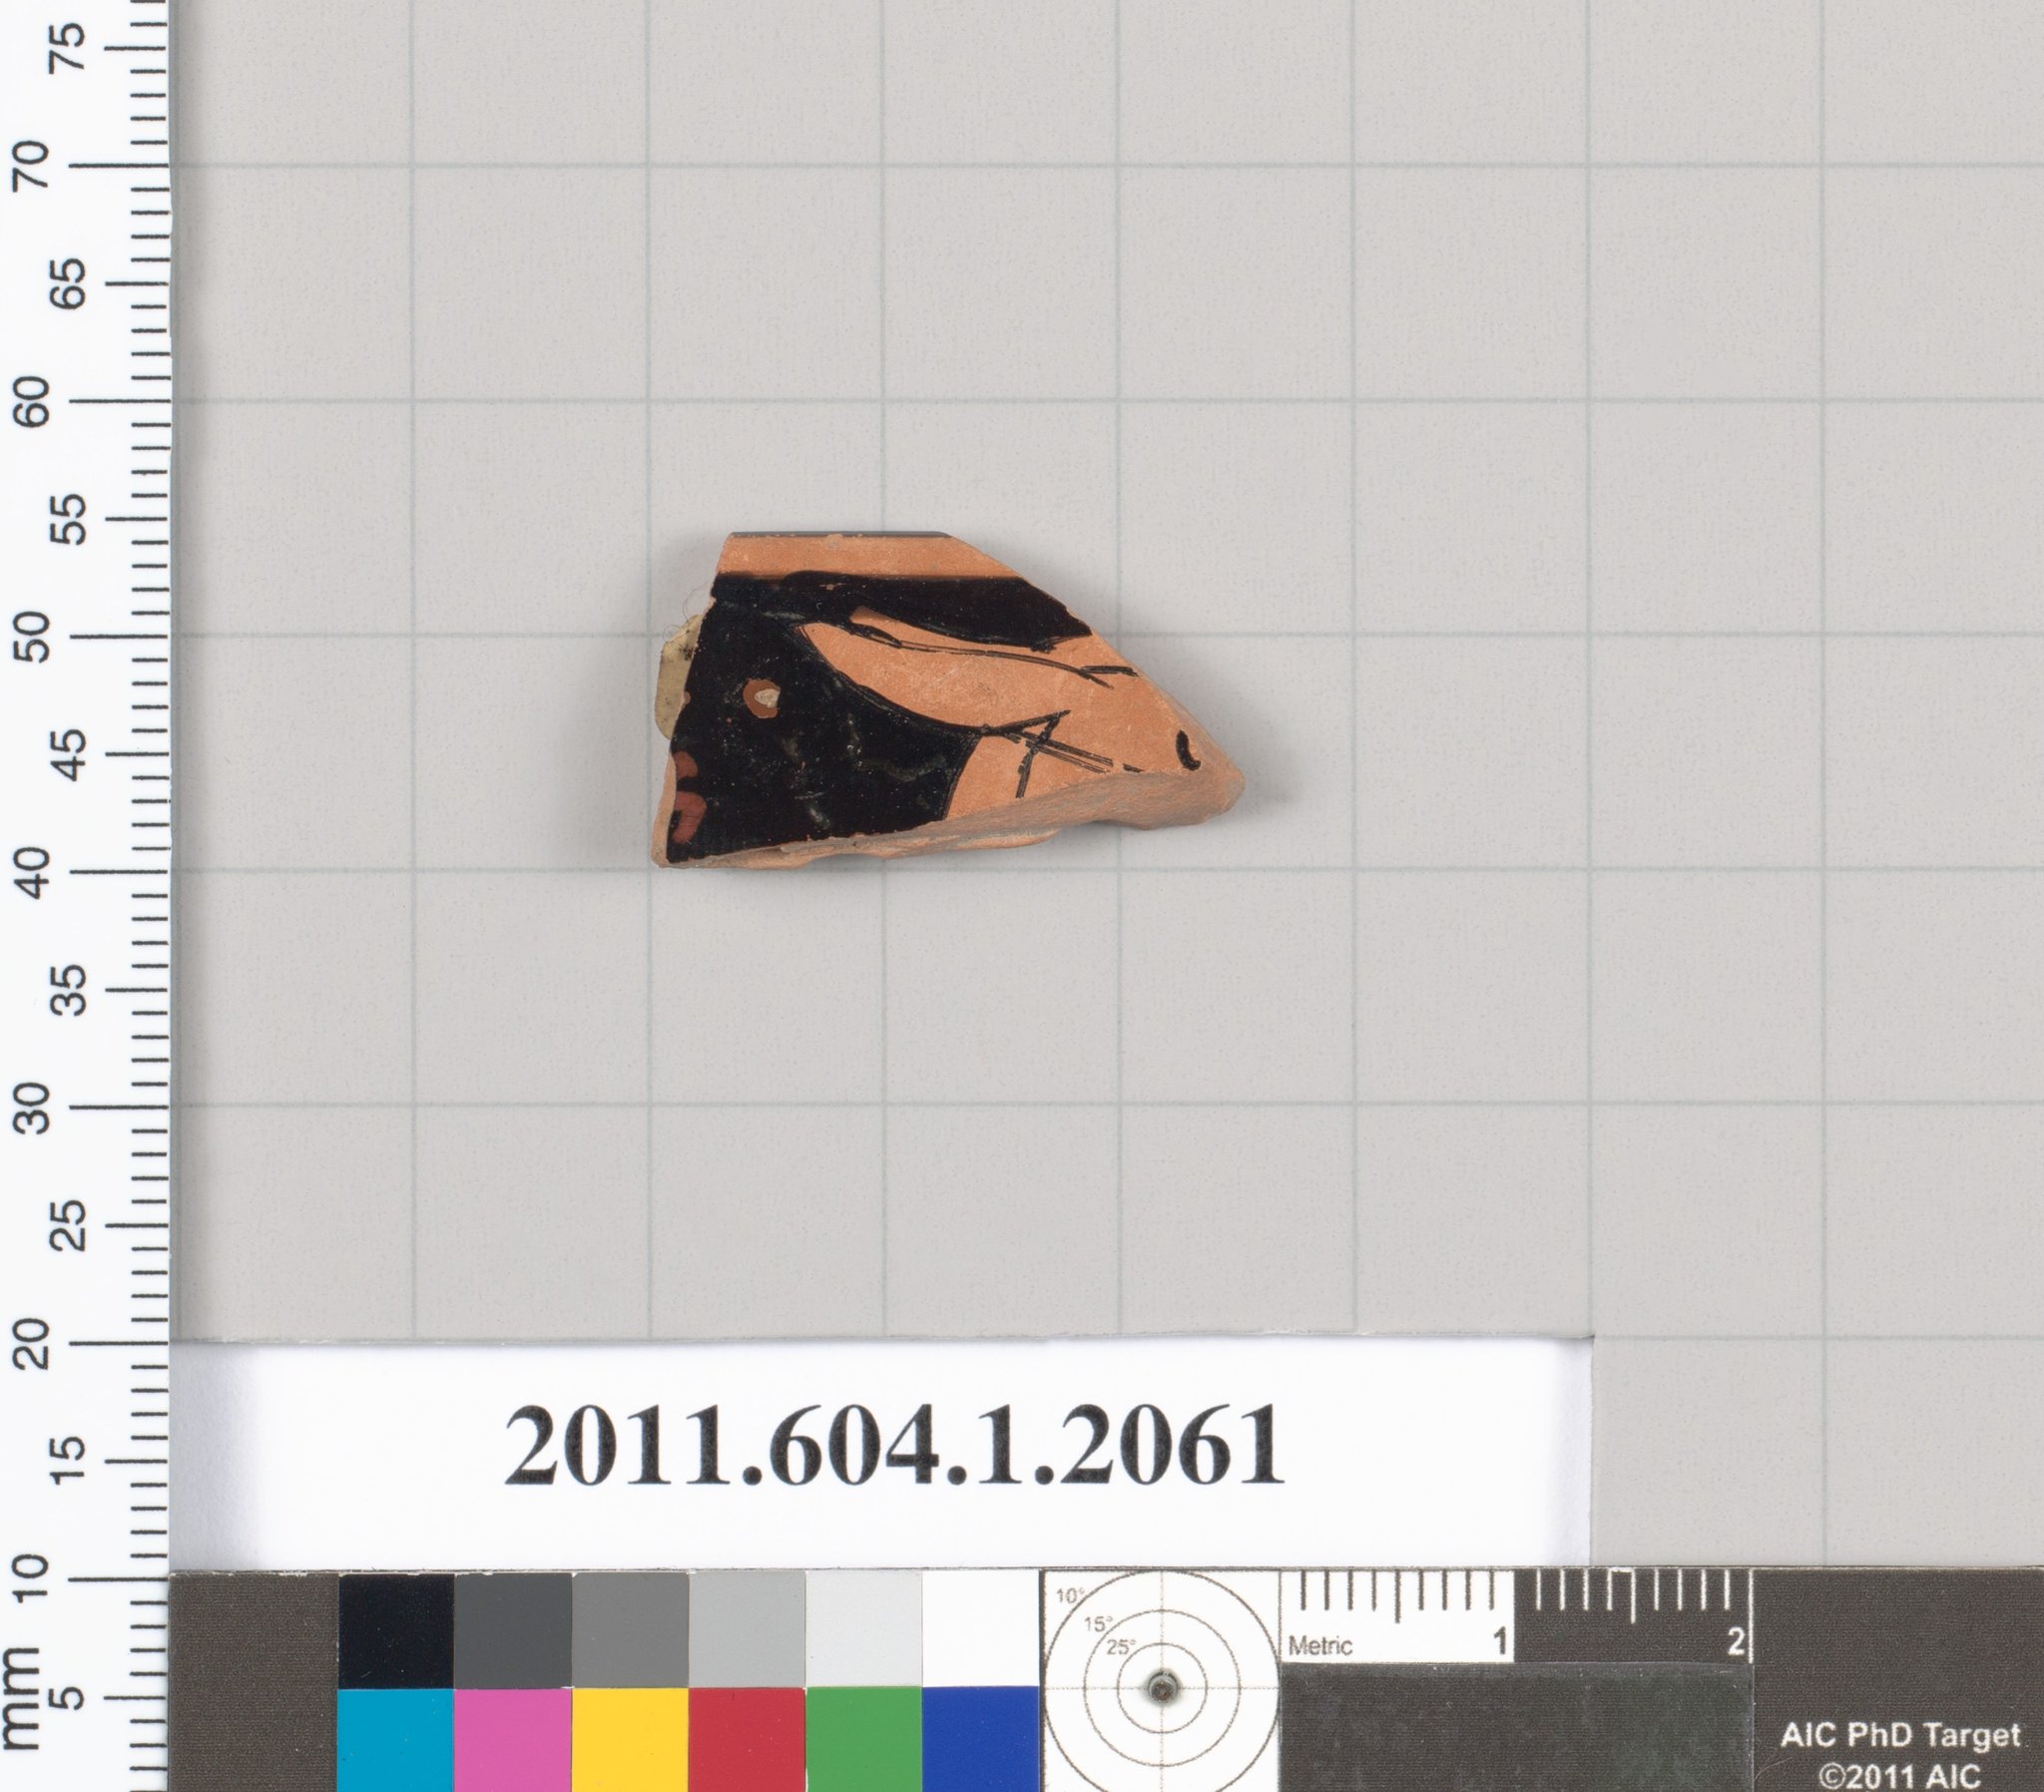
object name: kylix fragment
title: Terracotta rim fragment of a kylix (drinking cup)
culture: greek, attic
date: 475-451 BCE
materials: terracotta